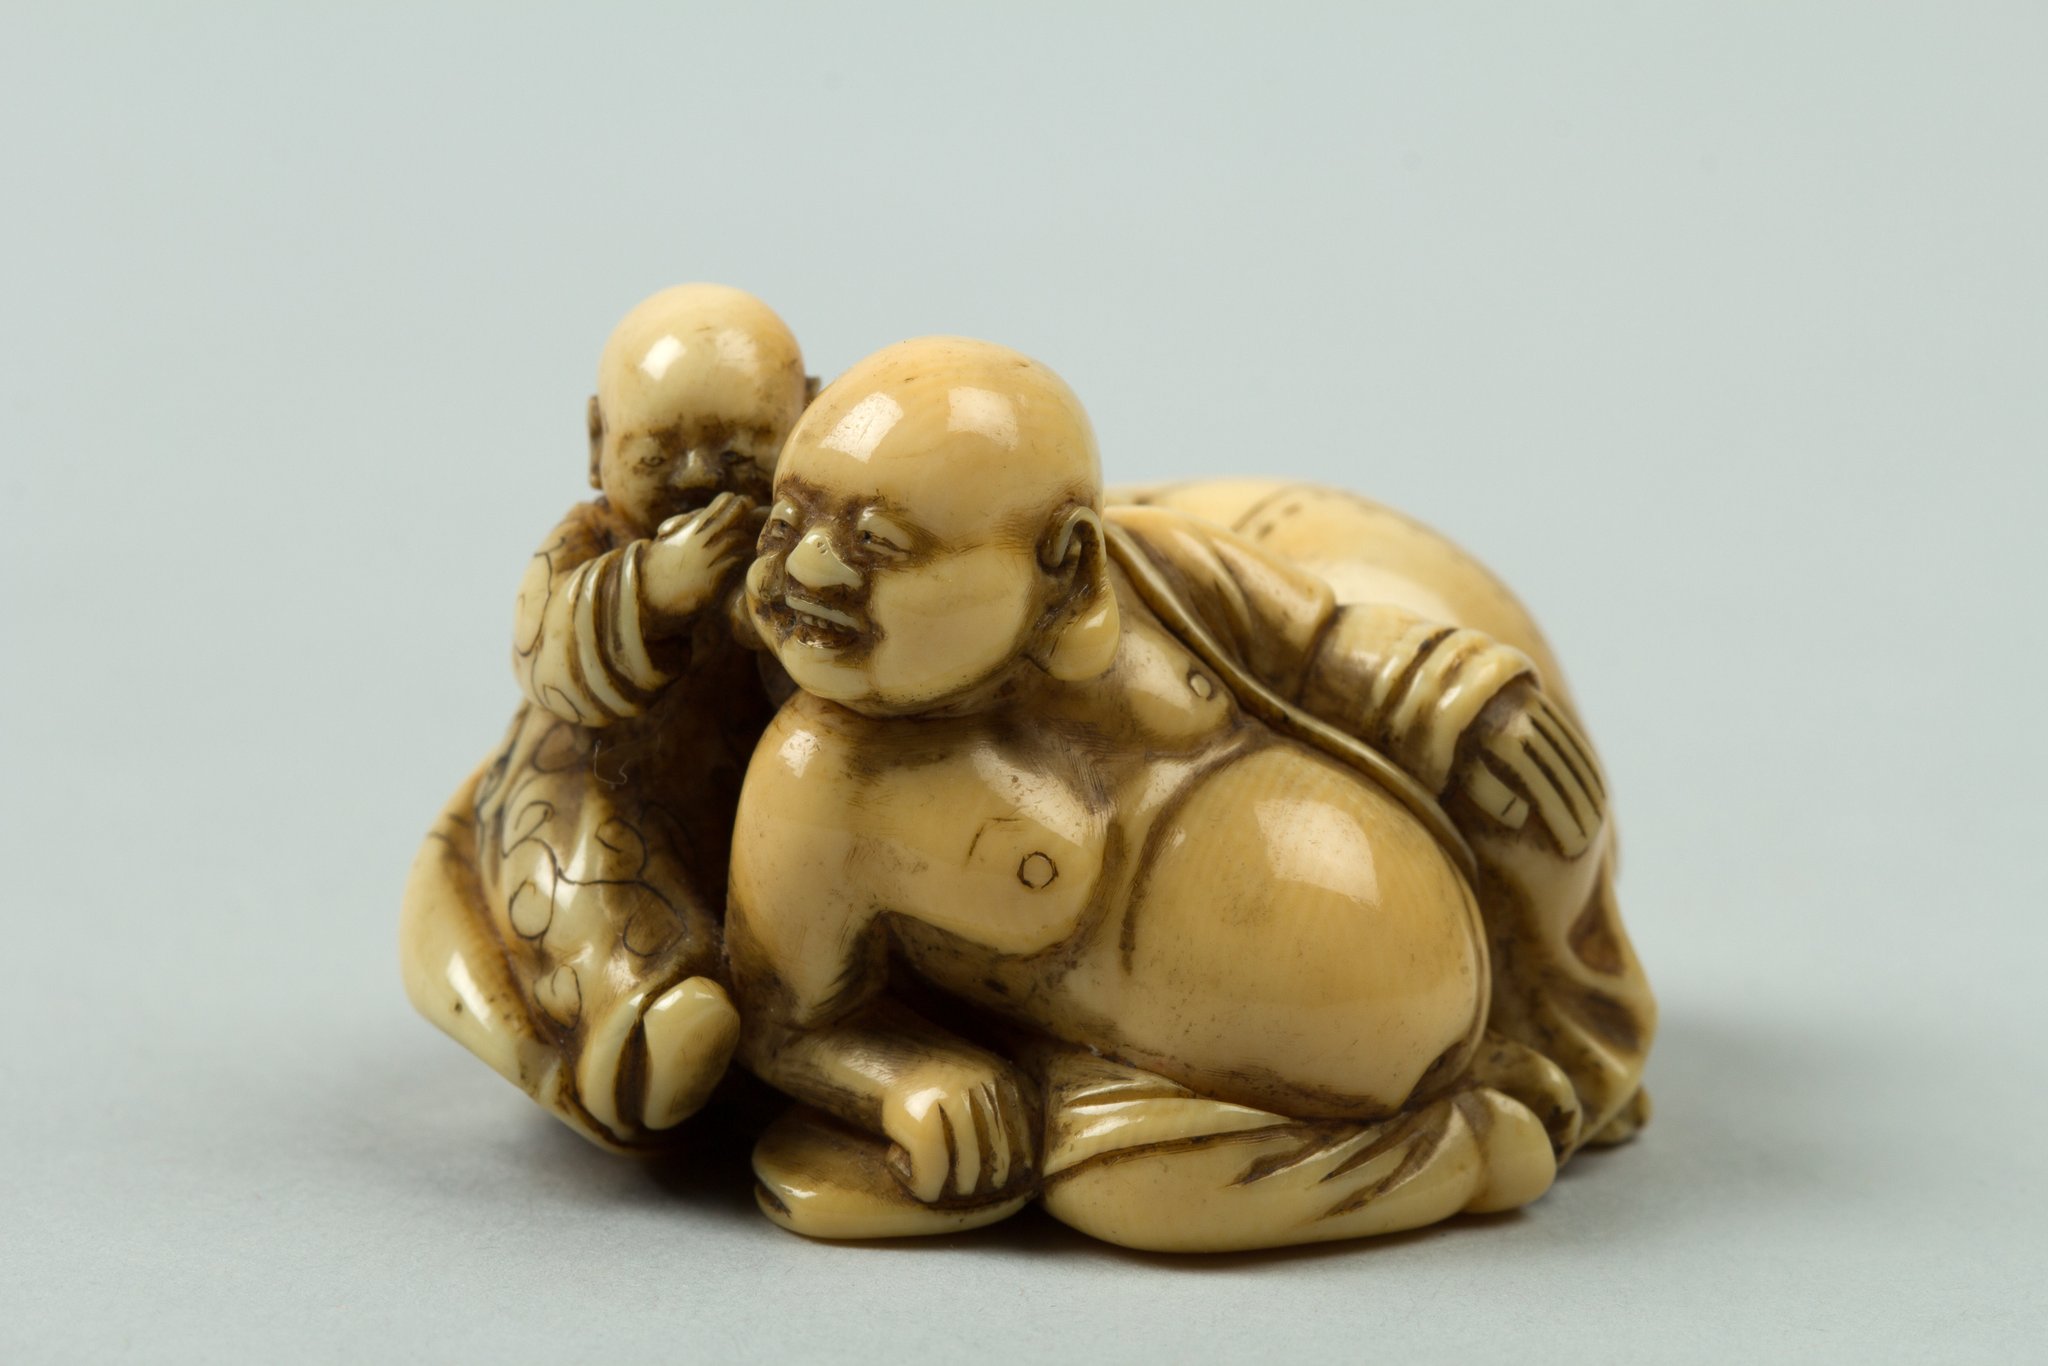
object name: netsuke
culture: japanese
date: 1801-1900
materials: ivory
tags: children,men